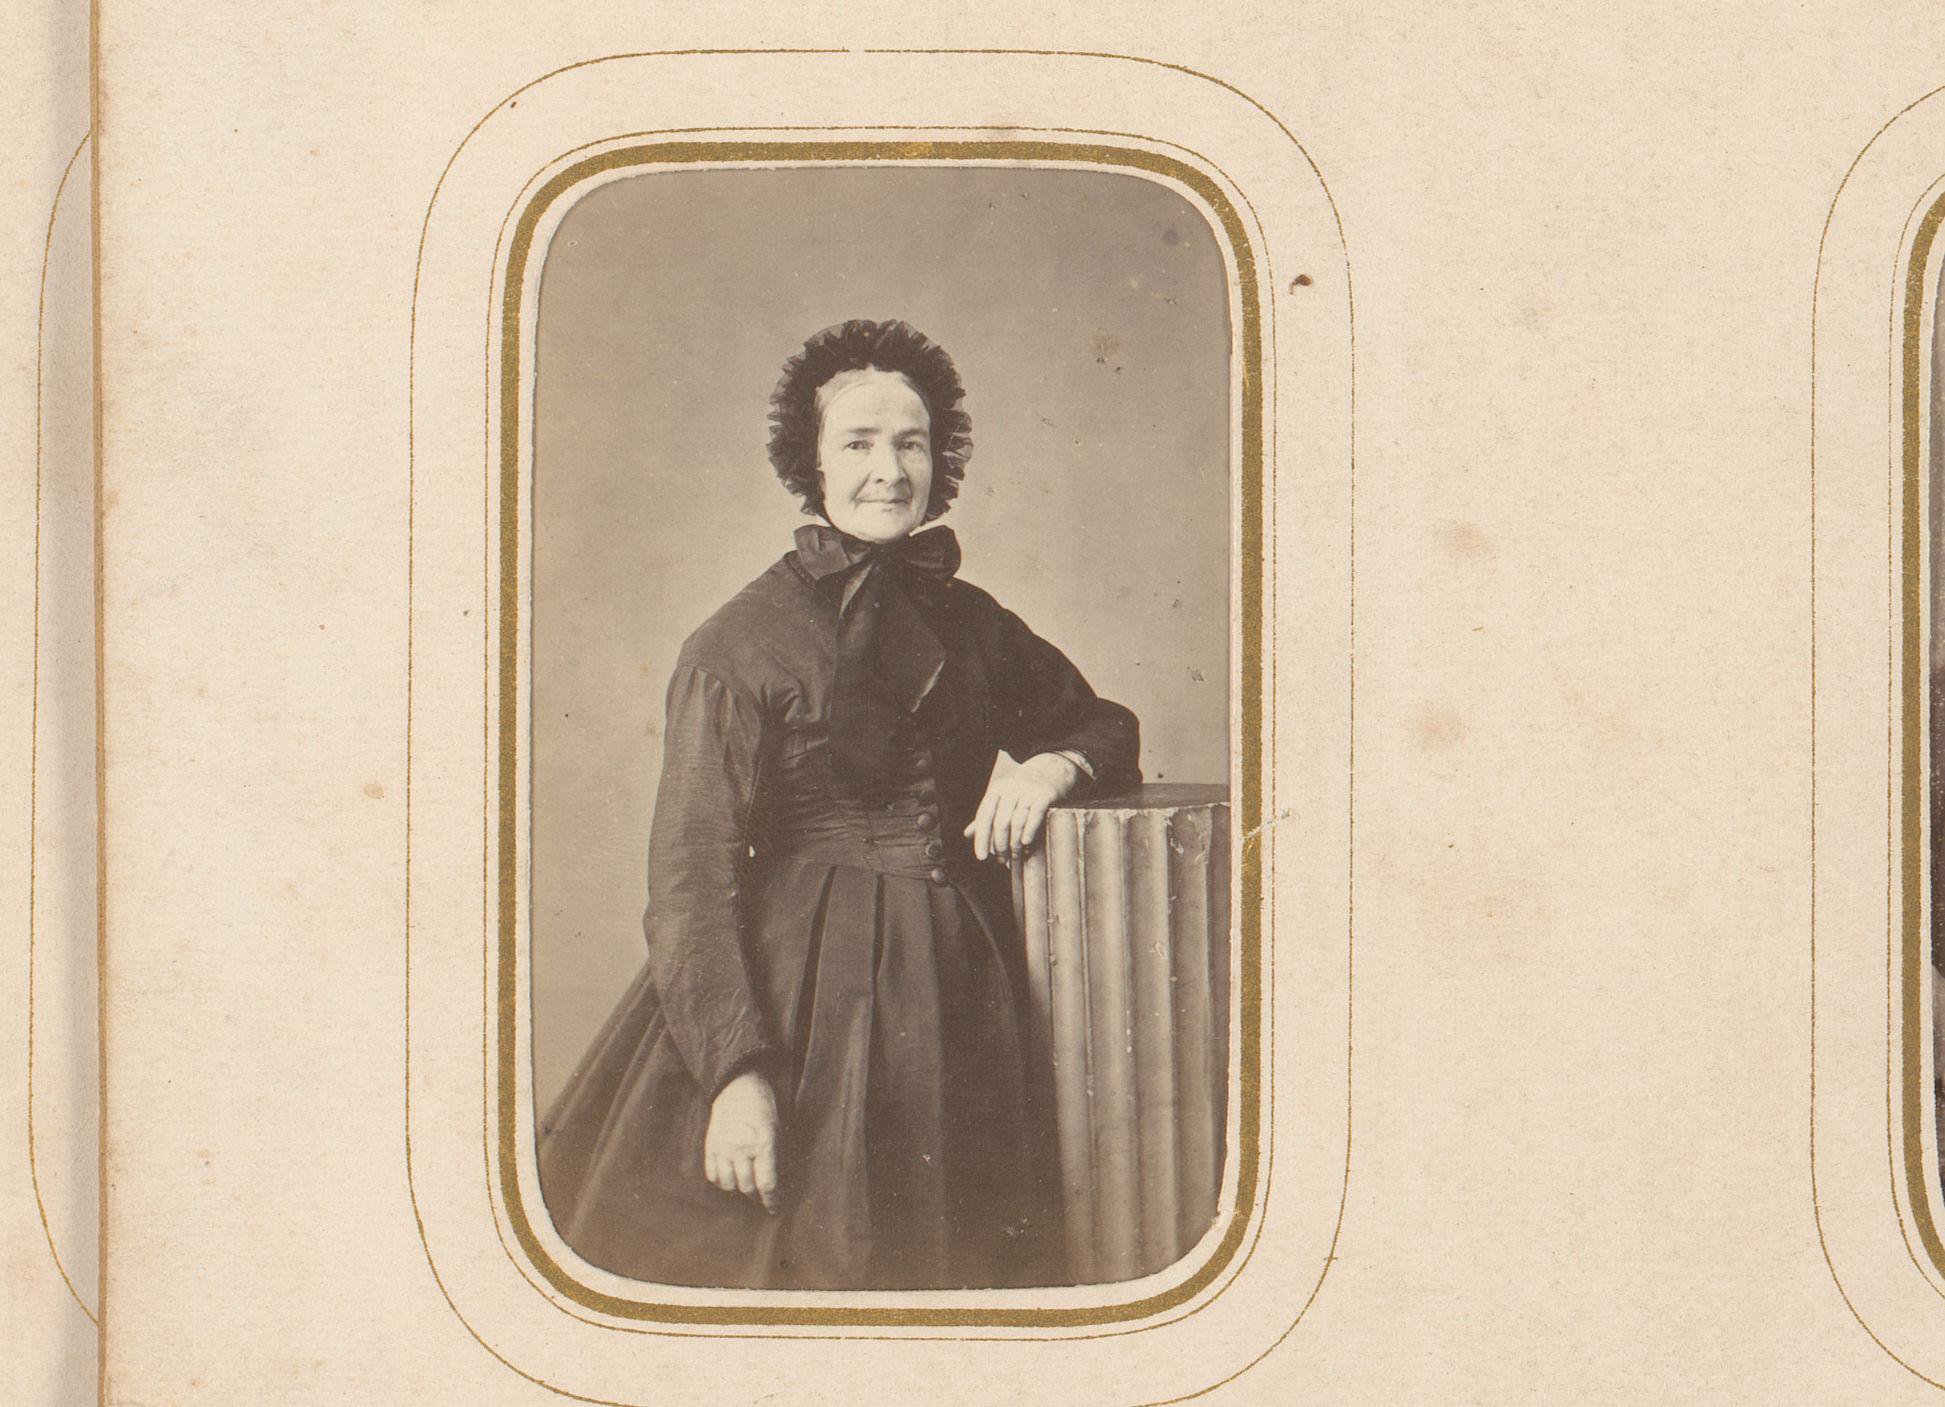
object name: photograph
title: Portret van een vrouw met muts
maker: albert collard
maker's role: fotograaf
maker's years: 1838-1887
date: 1850-1867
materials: cardboard, photographic support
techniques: albumen print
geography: paris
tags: historical persons - bb - woman, head-gear: hat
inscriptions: inscription: ‘Collard Phot/ Des ponts & Chaussees’, inscription: ‘Atelier Central de Photographie/ Collard/ 39, Boulevart de Strasbourg/ Paris’